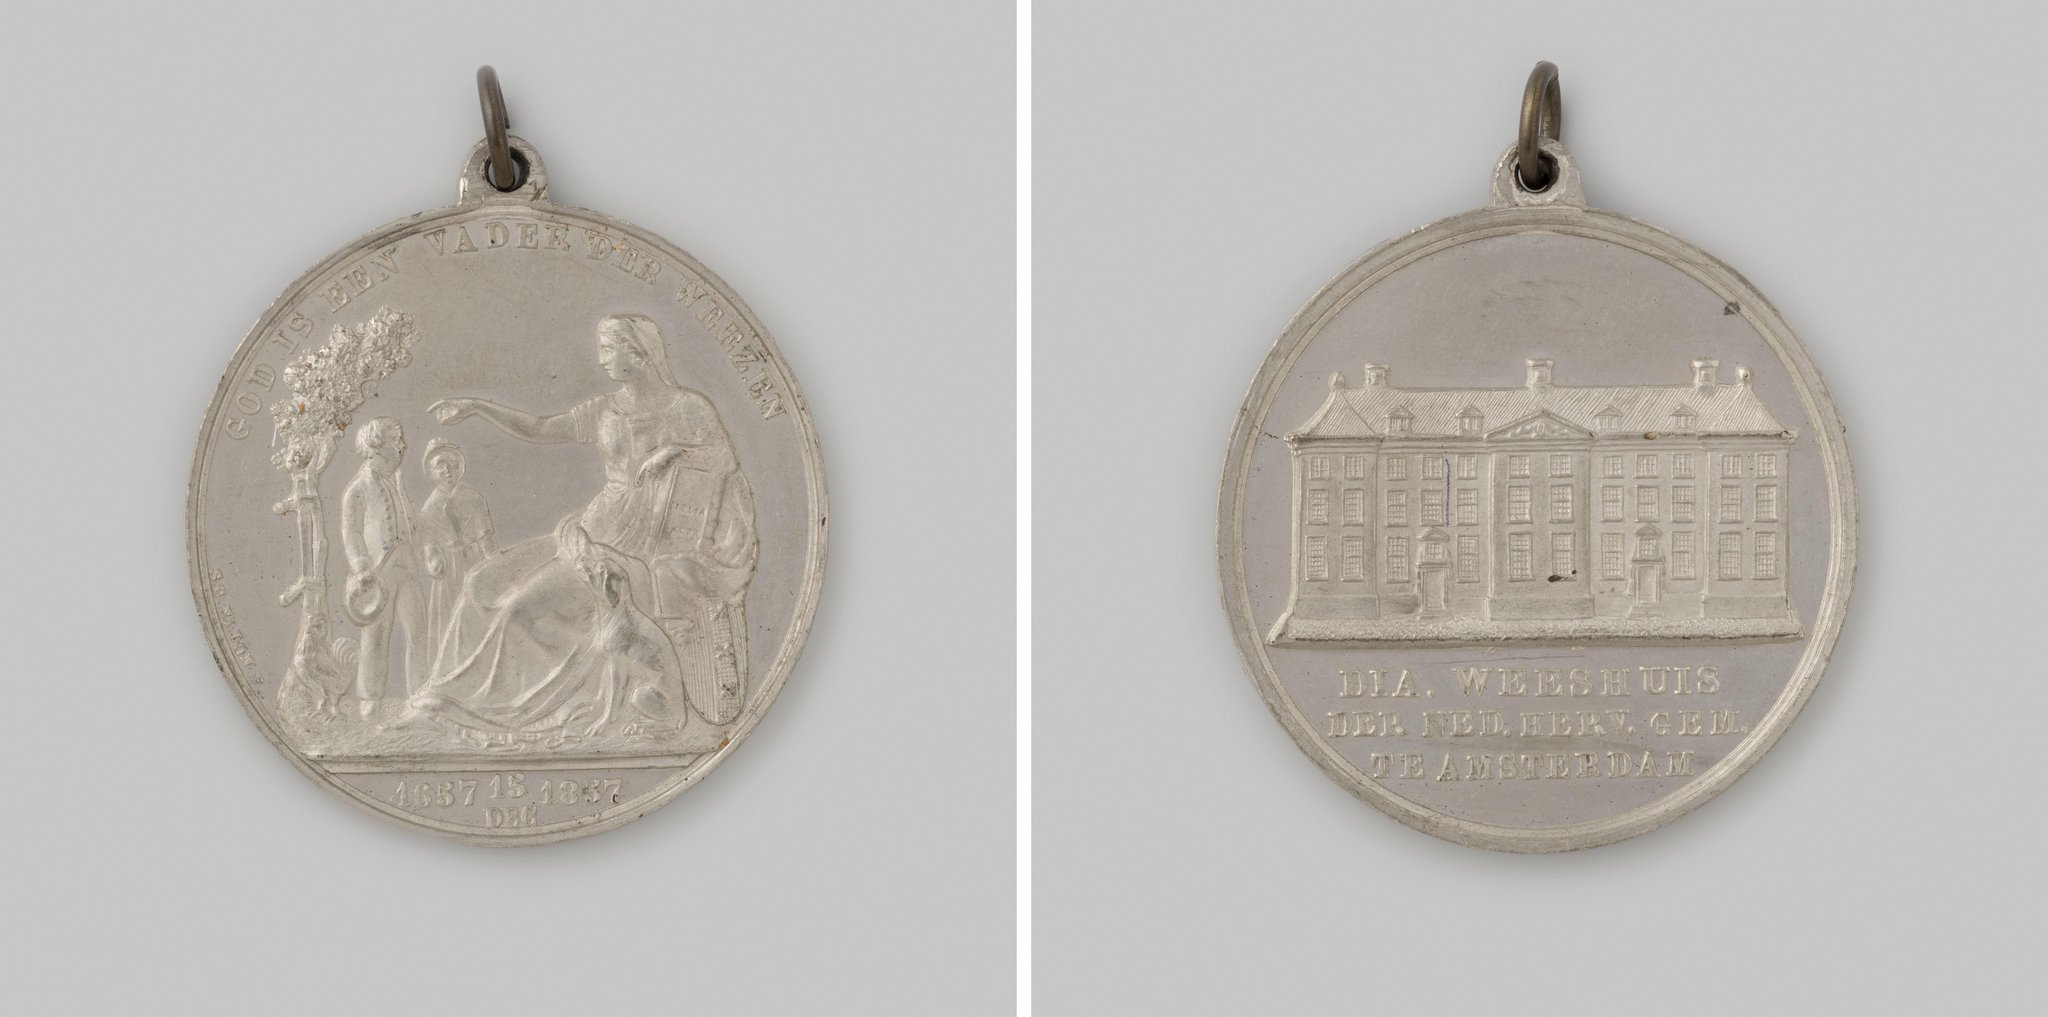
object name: history medal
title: Tweehonderjarig bestaan van het diakonie weeshuis der Nederduitsch Hervormde Gemeente te Amsterdam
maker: samuel cohen elion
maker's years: 1815-1880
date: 1857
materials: silver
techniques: striking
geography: amsterdam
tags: orphanage, amsterdam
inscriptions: inscription: ‘GOD IS EEN VADER DER WEEZEN’, inscription: ‘BIBLIA SACRA’, inscription: ‘DIA . WEESHUIS DER NED. HERV. GEM. TE AMSTERDAM’